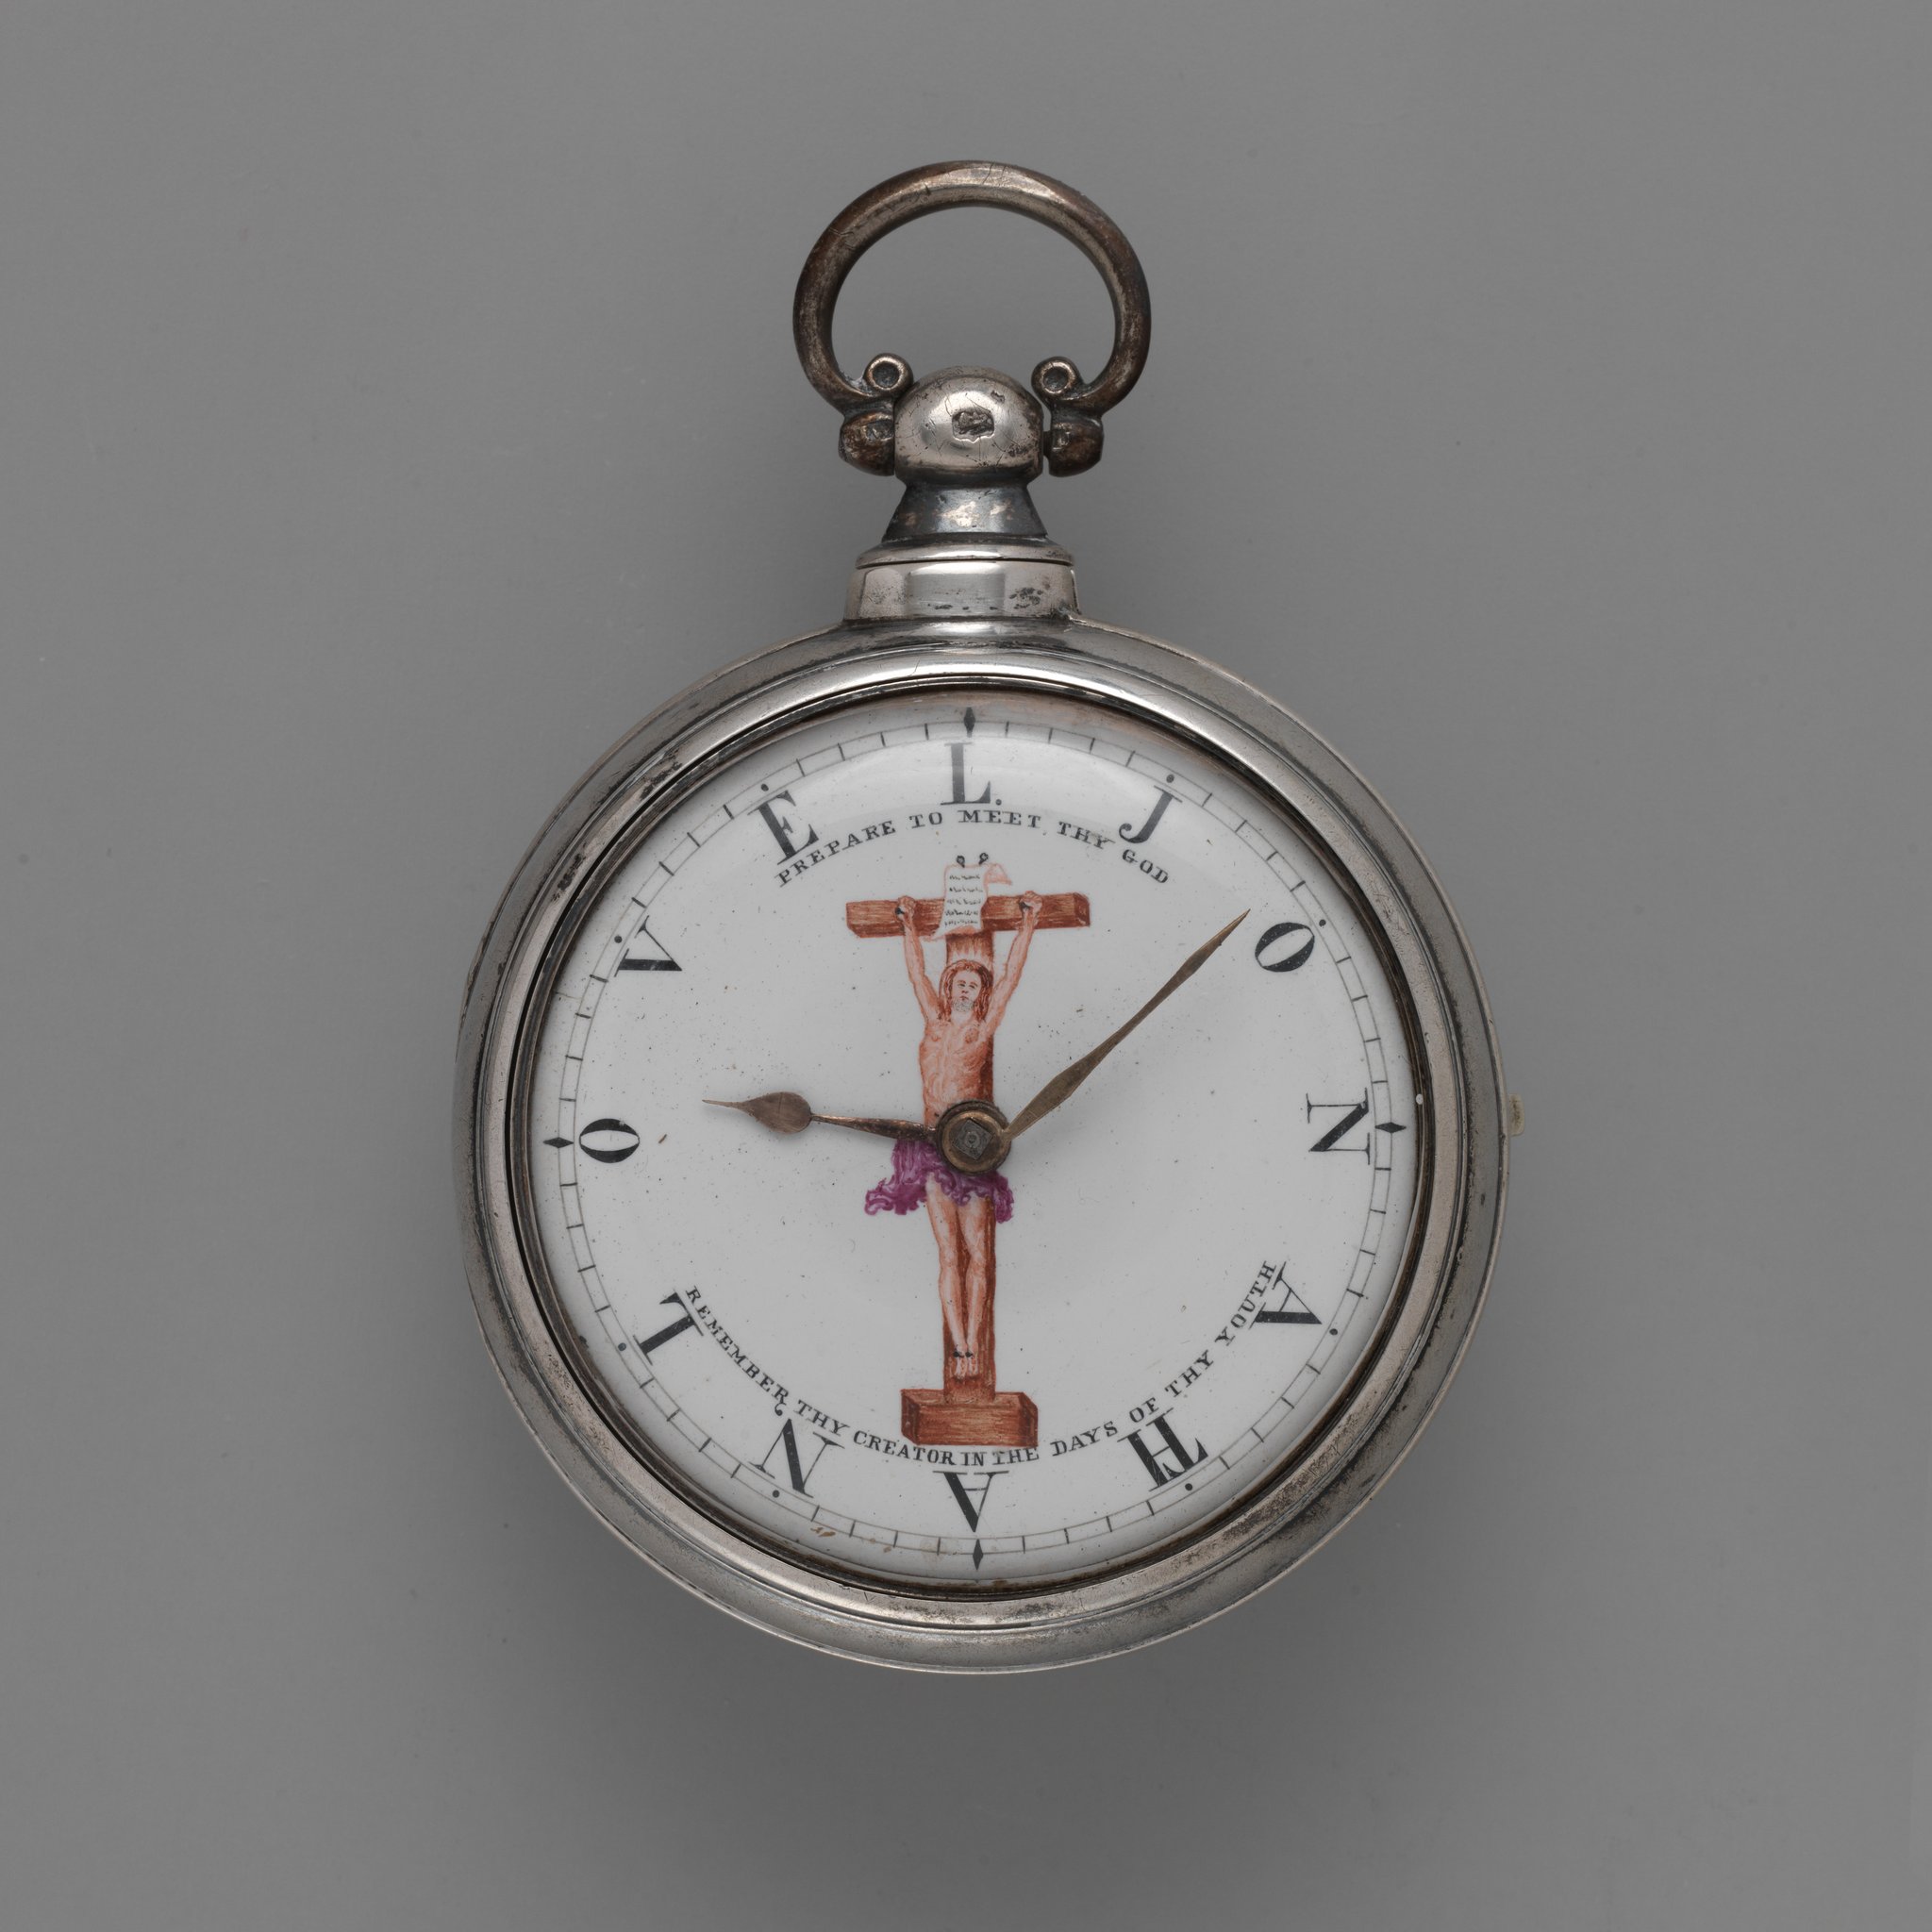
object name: watch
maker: f. dobson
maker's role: maker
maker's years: 1800-1900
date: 1801-1900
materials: silver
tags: jesus